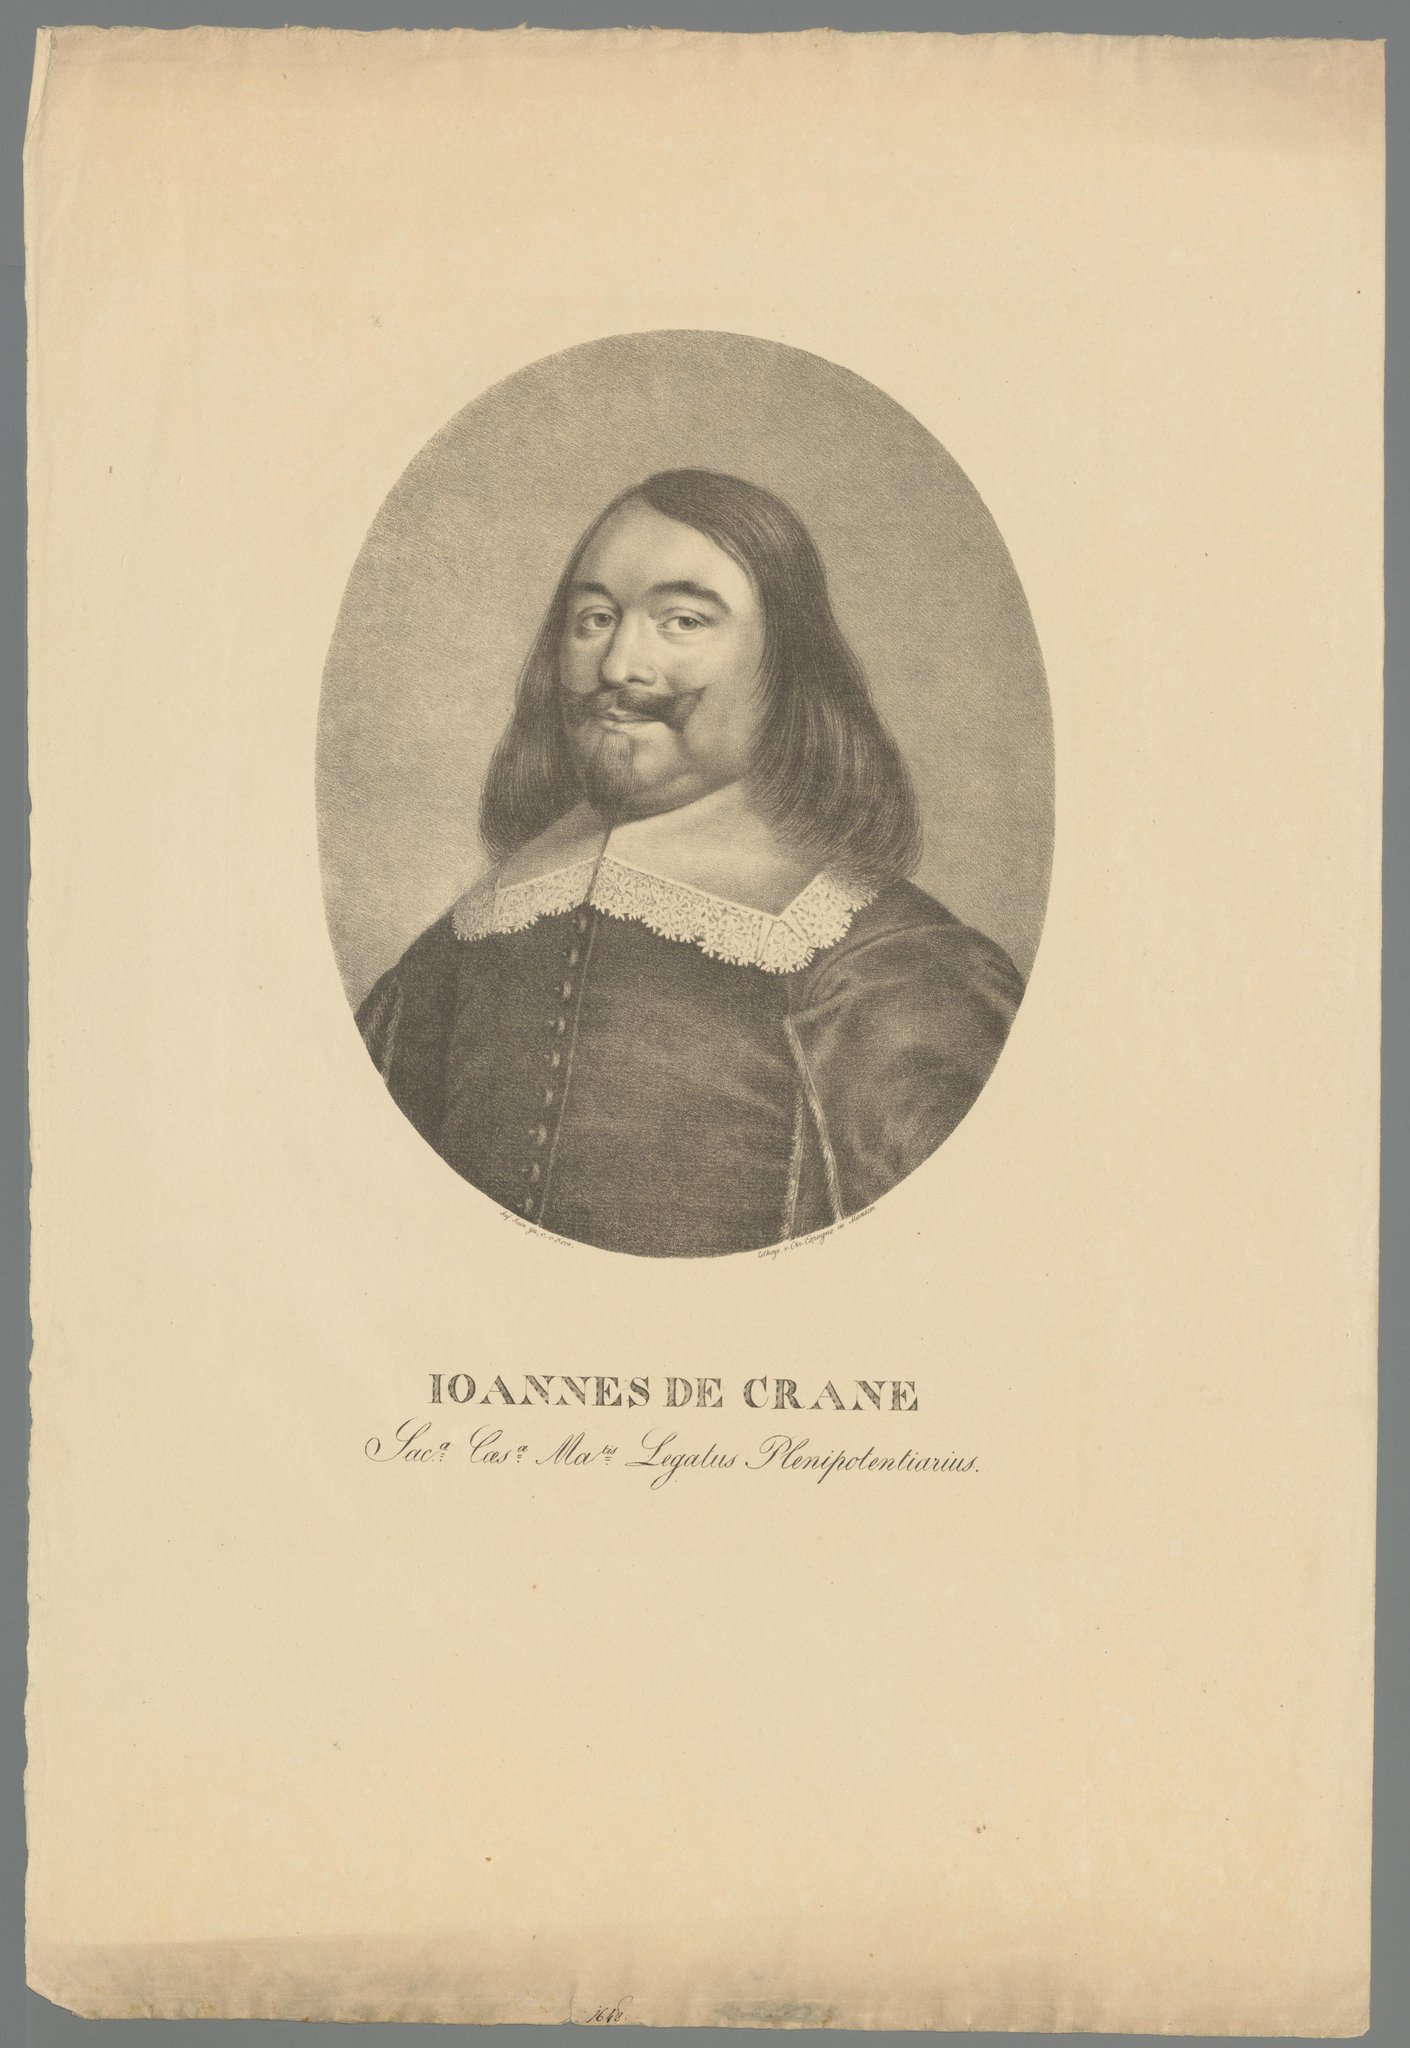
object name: print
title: Ioannes de Crane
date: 1804-1838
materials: paper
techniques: lithograph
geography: munster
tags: adult man, historical persons, beard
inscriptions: collector's mark: Lugt 2228